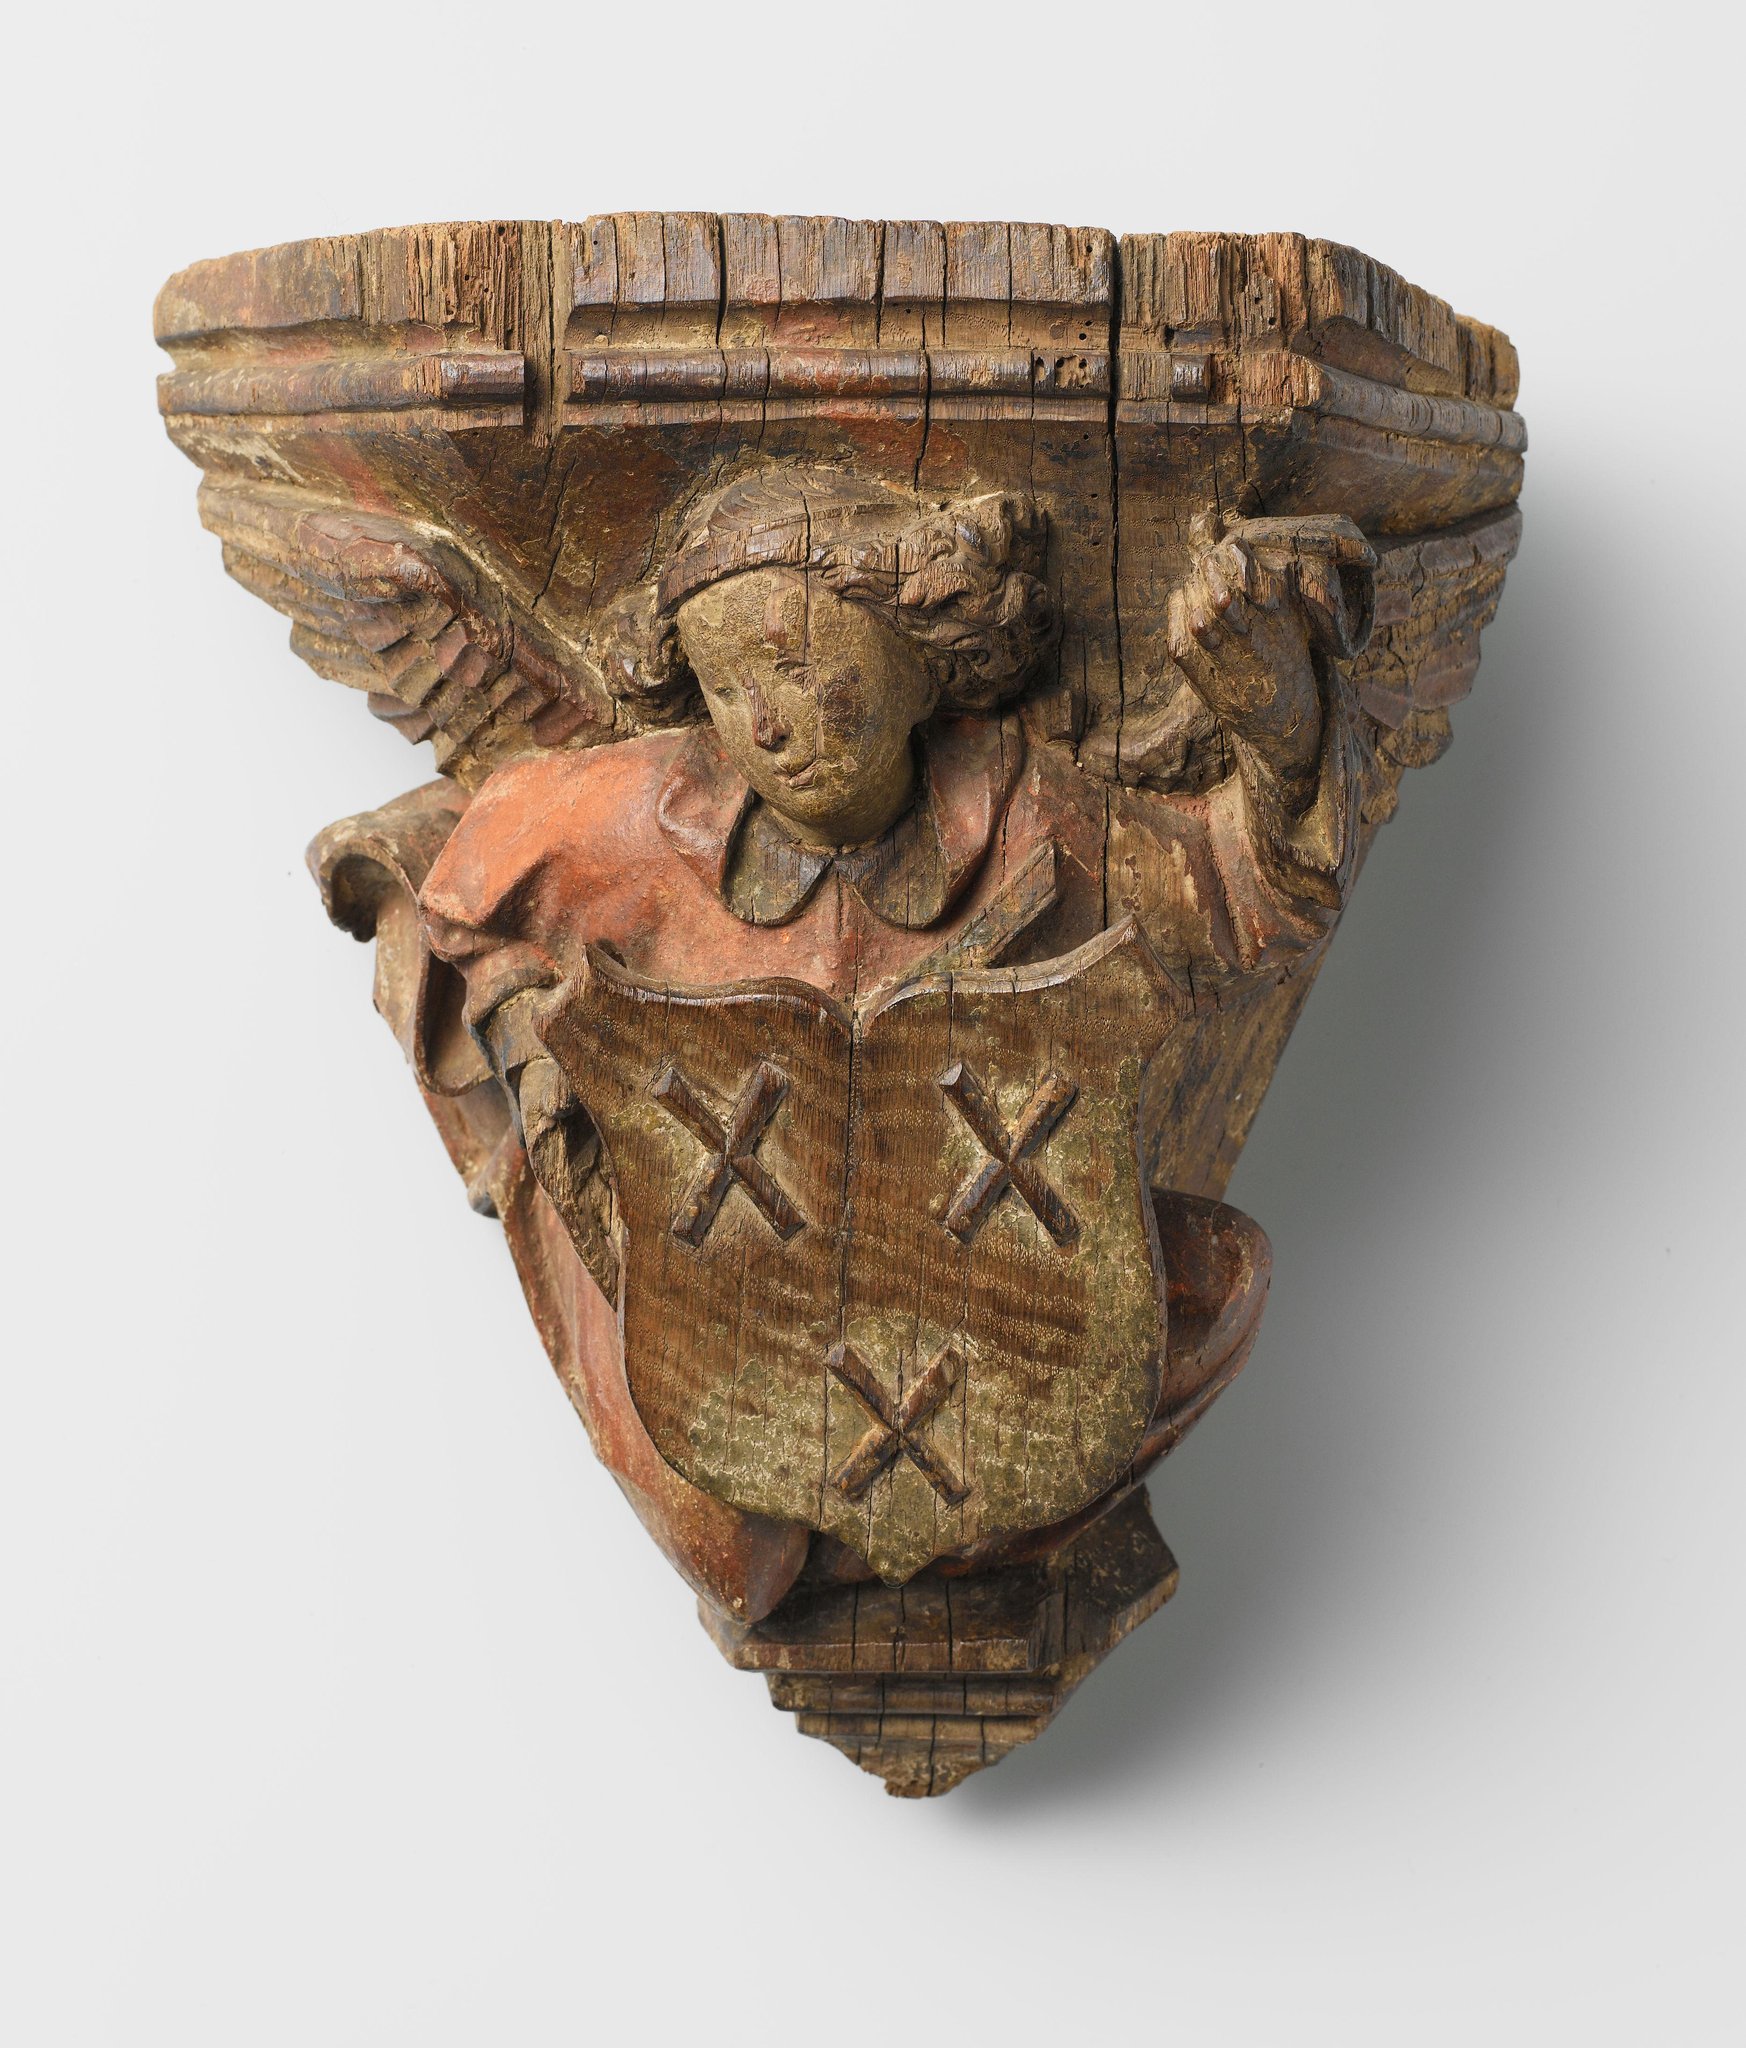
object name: console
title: Angel Corbel with the Coat-of-Arms of Breda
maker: Anonymous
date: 1500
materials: wood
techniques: gilding, polychromy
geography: brabant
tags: specific aspects of angels, e.g. intervening in human affairs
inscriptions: coat of arms, on the escutcheon in the angel’s hands, in relief: three saltires (arms of Breda)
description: De engel zweeft, één knie opgetrokken, het andere been naar achteren gebogen. Zijn haren waaien krullend naar achteren en de mantel (als van een diaken) wappert alsof hij zojuist is neergestreken. Hij heeft het hoofd naar rechts gewend. De rechterhand verdwijnt achter het wapenschild. De linkerhand is opgeheven en houdt een stuk stof vast, mogelijk een deels afgebroken draperie. De vleugels volgen de vorm van de sokkel.